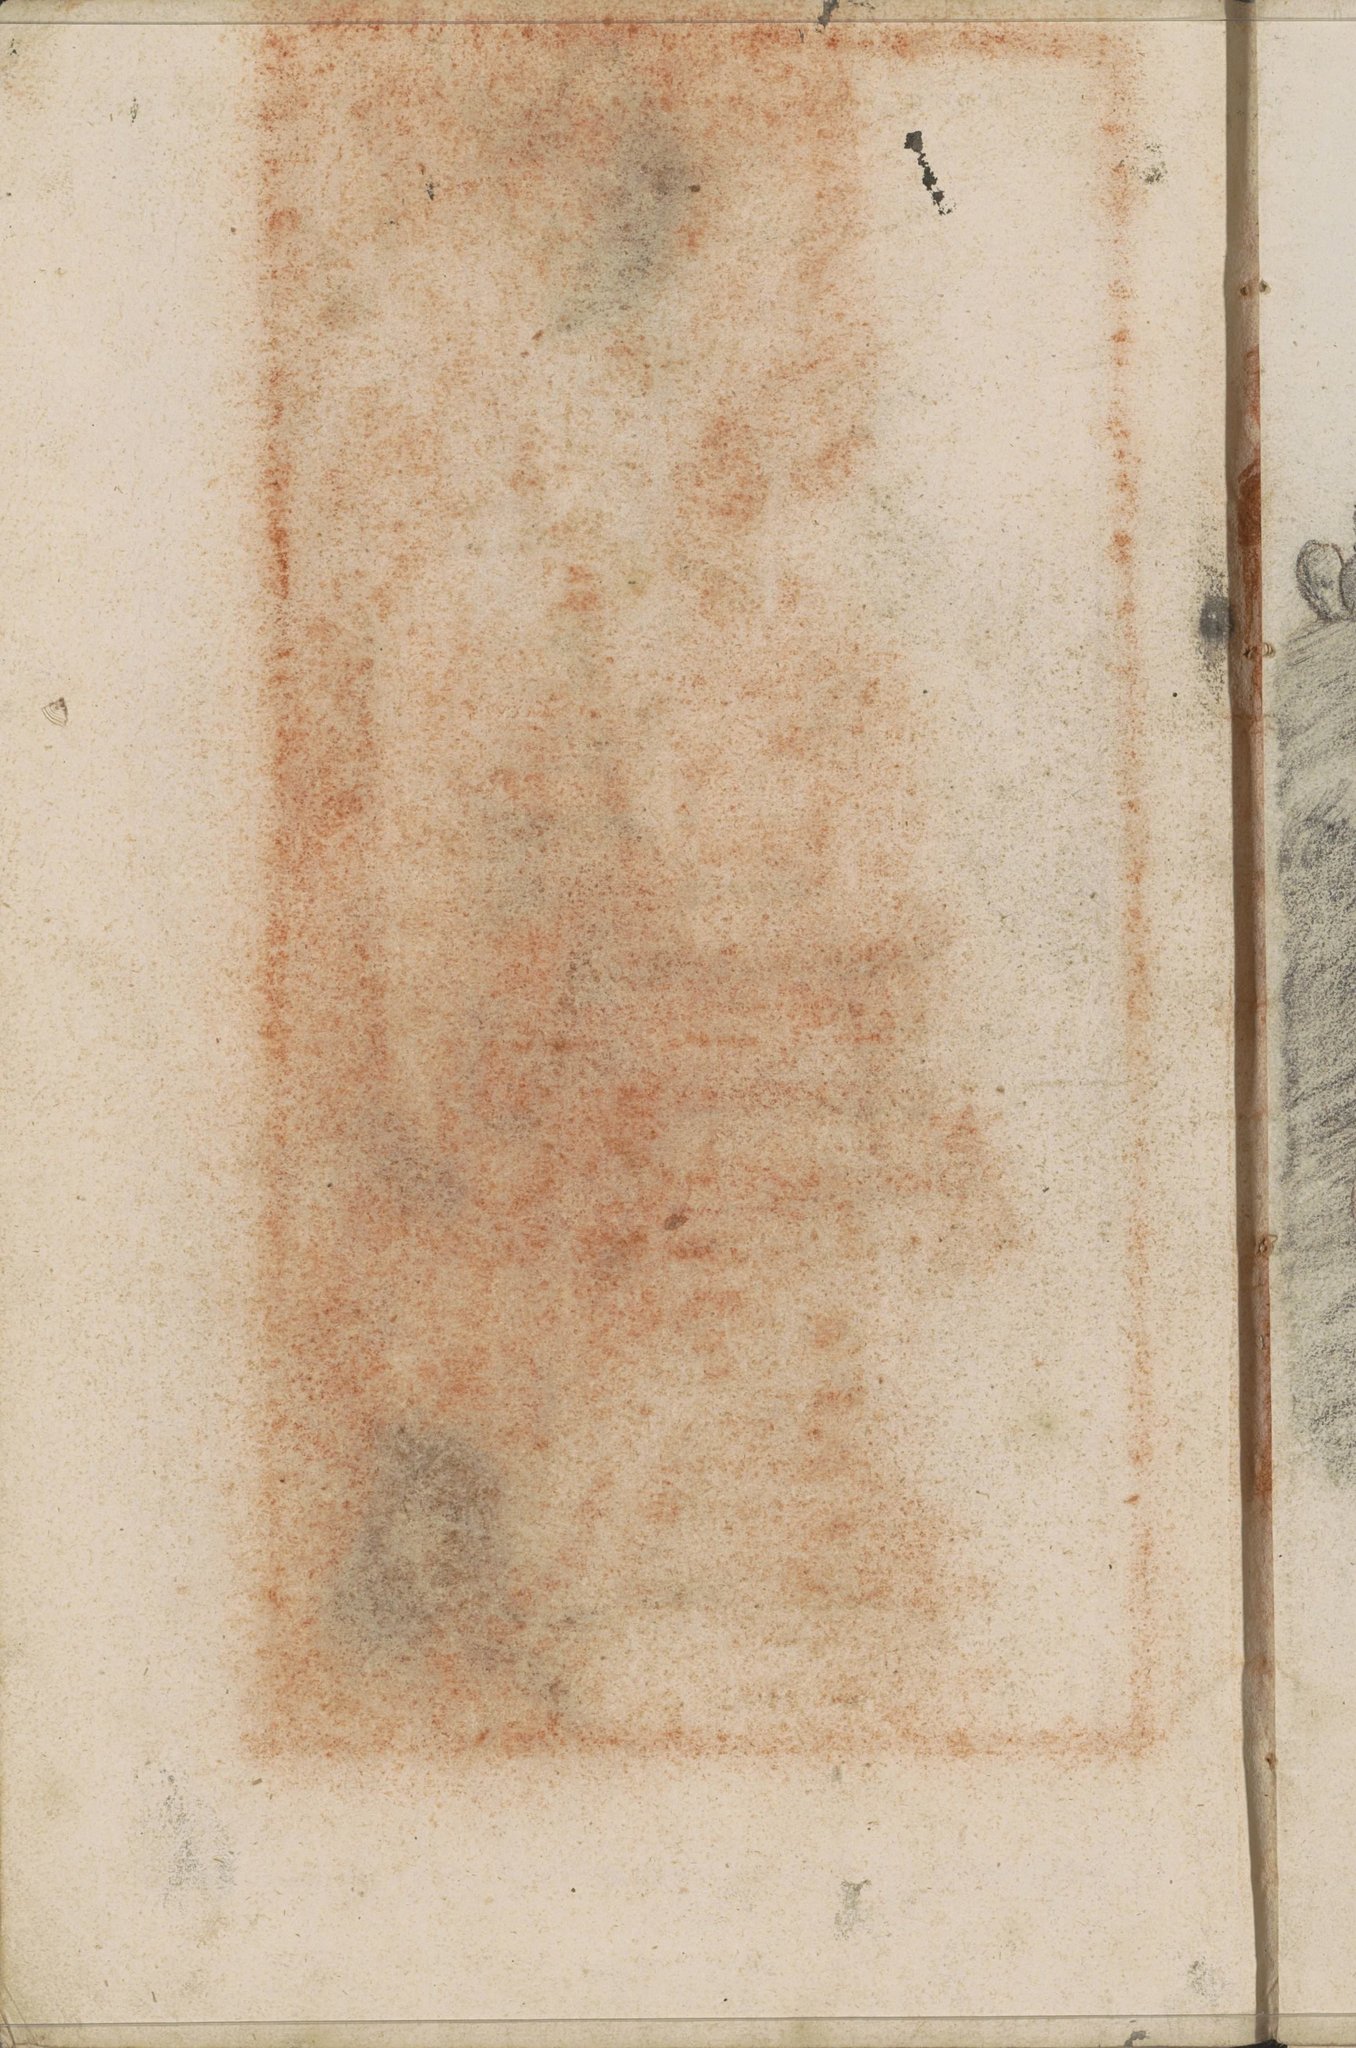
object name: sketchbook leaf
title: Abklatsch van een krijttekening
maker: hendrick van beaumont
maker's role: draughtsman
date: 1696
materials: paper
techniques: printmaking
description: De tekening, vermoedelijk van een stadsgezicht, is niet langer aanwezig in het schetsboek. Blad 6 verso uit een schetsboek met 30 bladen.